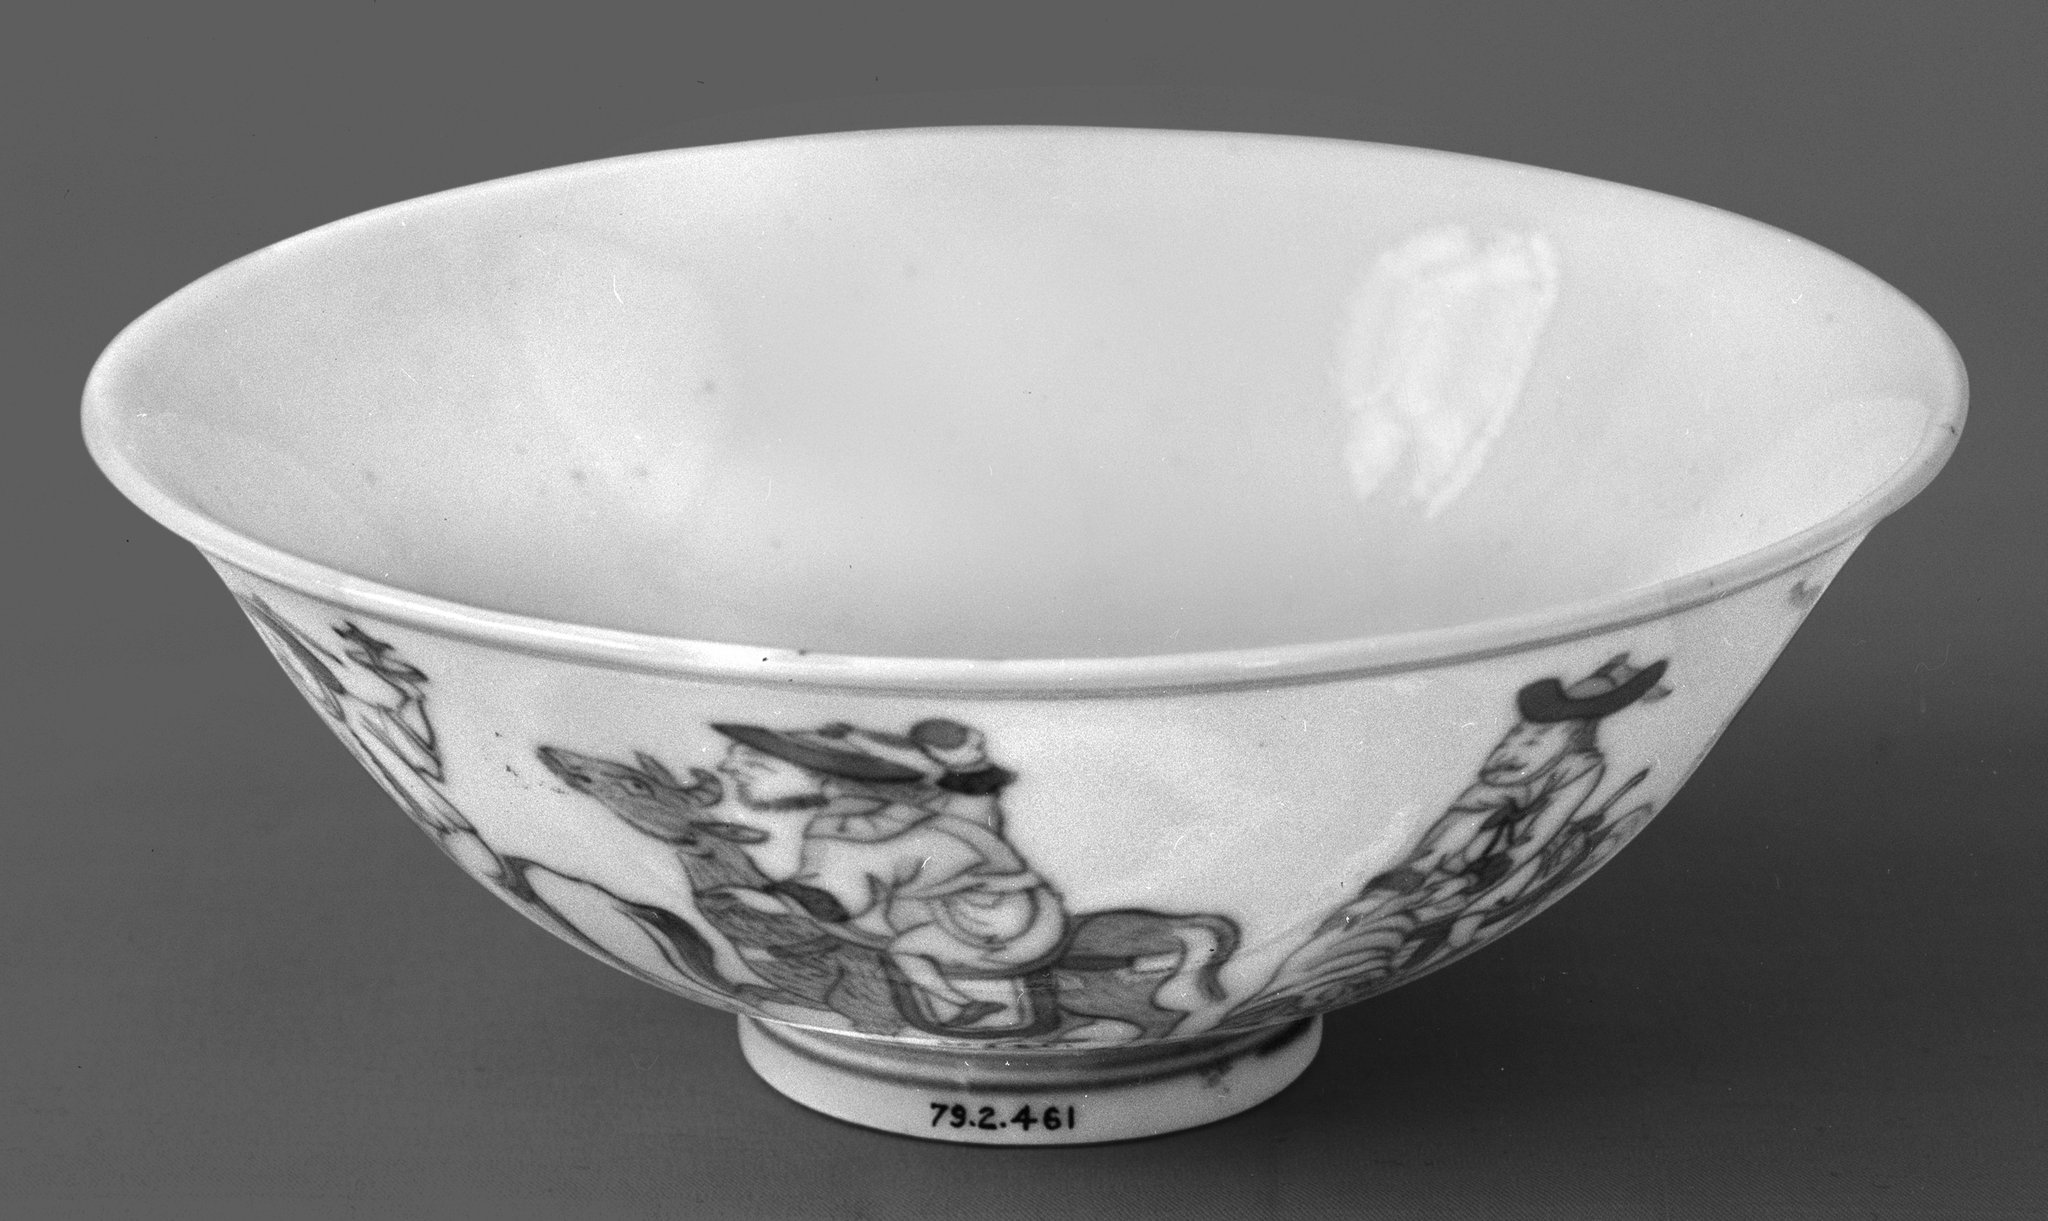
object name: bowl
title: Bowl with foreign tributers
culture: chinese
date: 1801-1833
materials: cobalt, porcelain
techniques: painting, underglaze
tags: horses